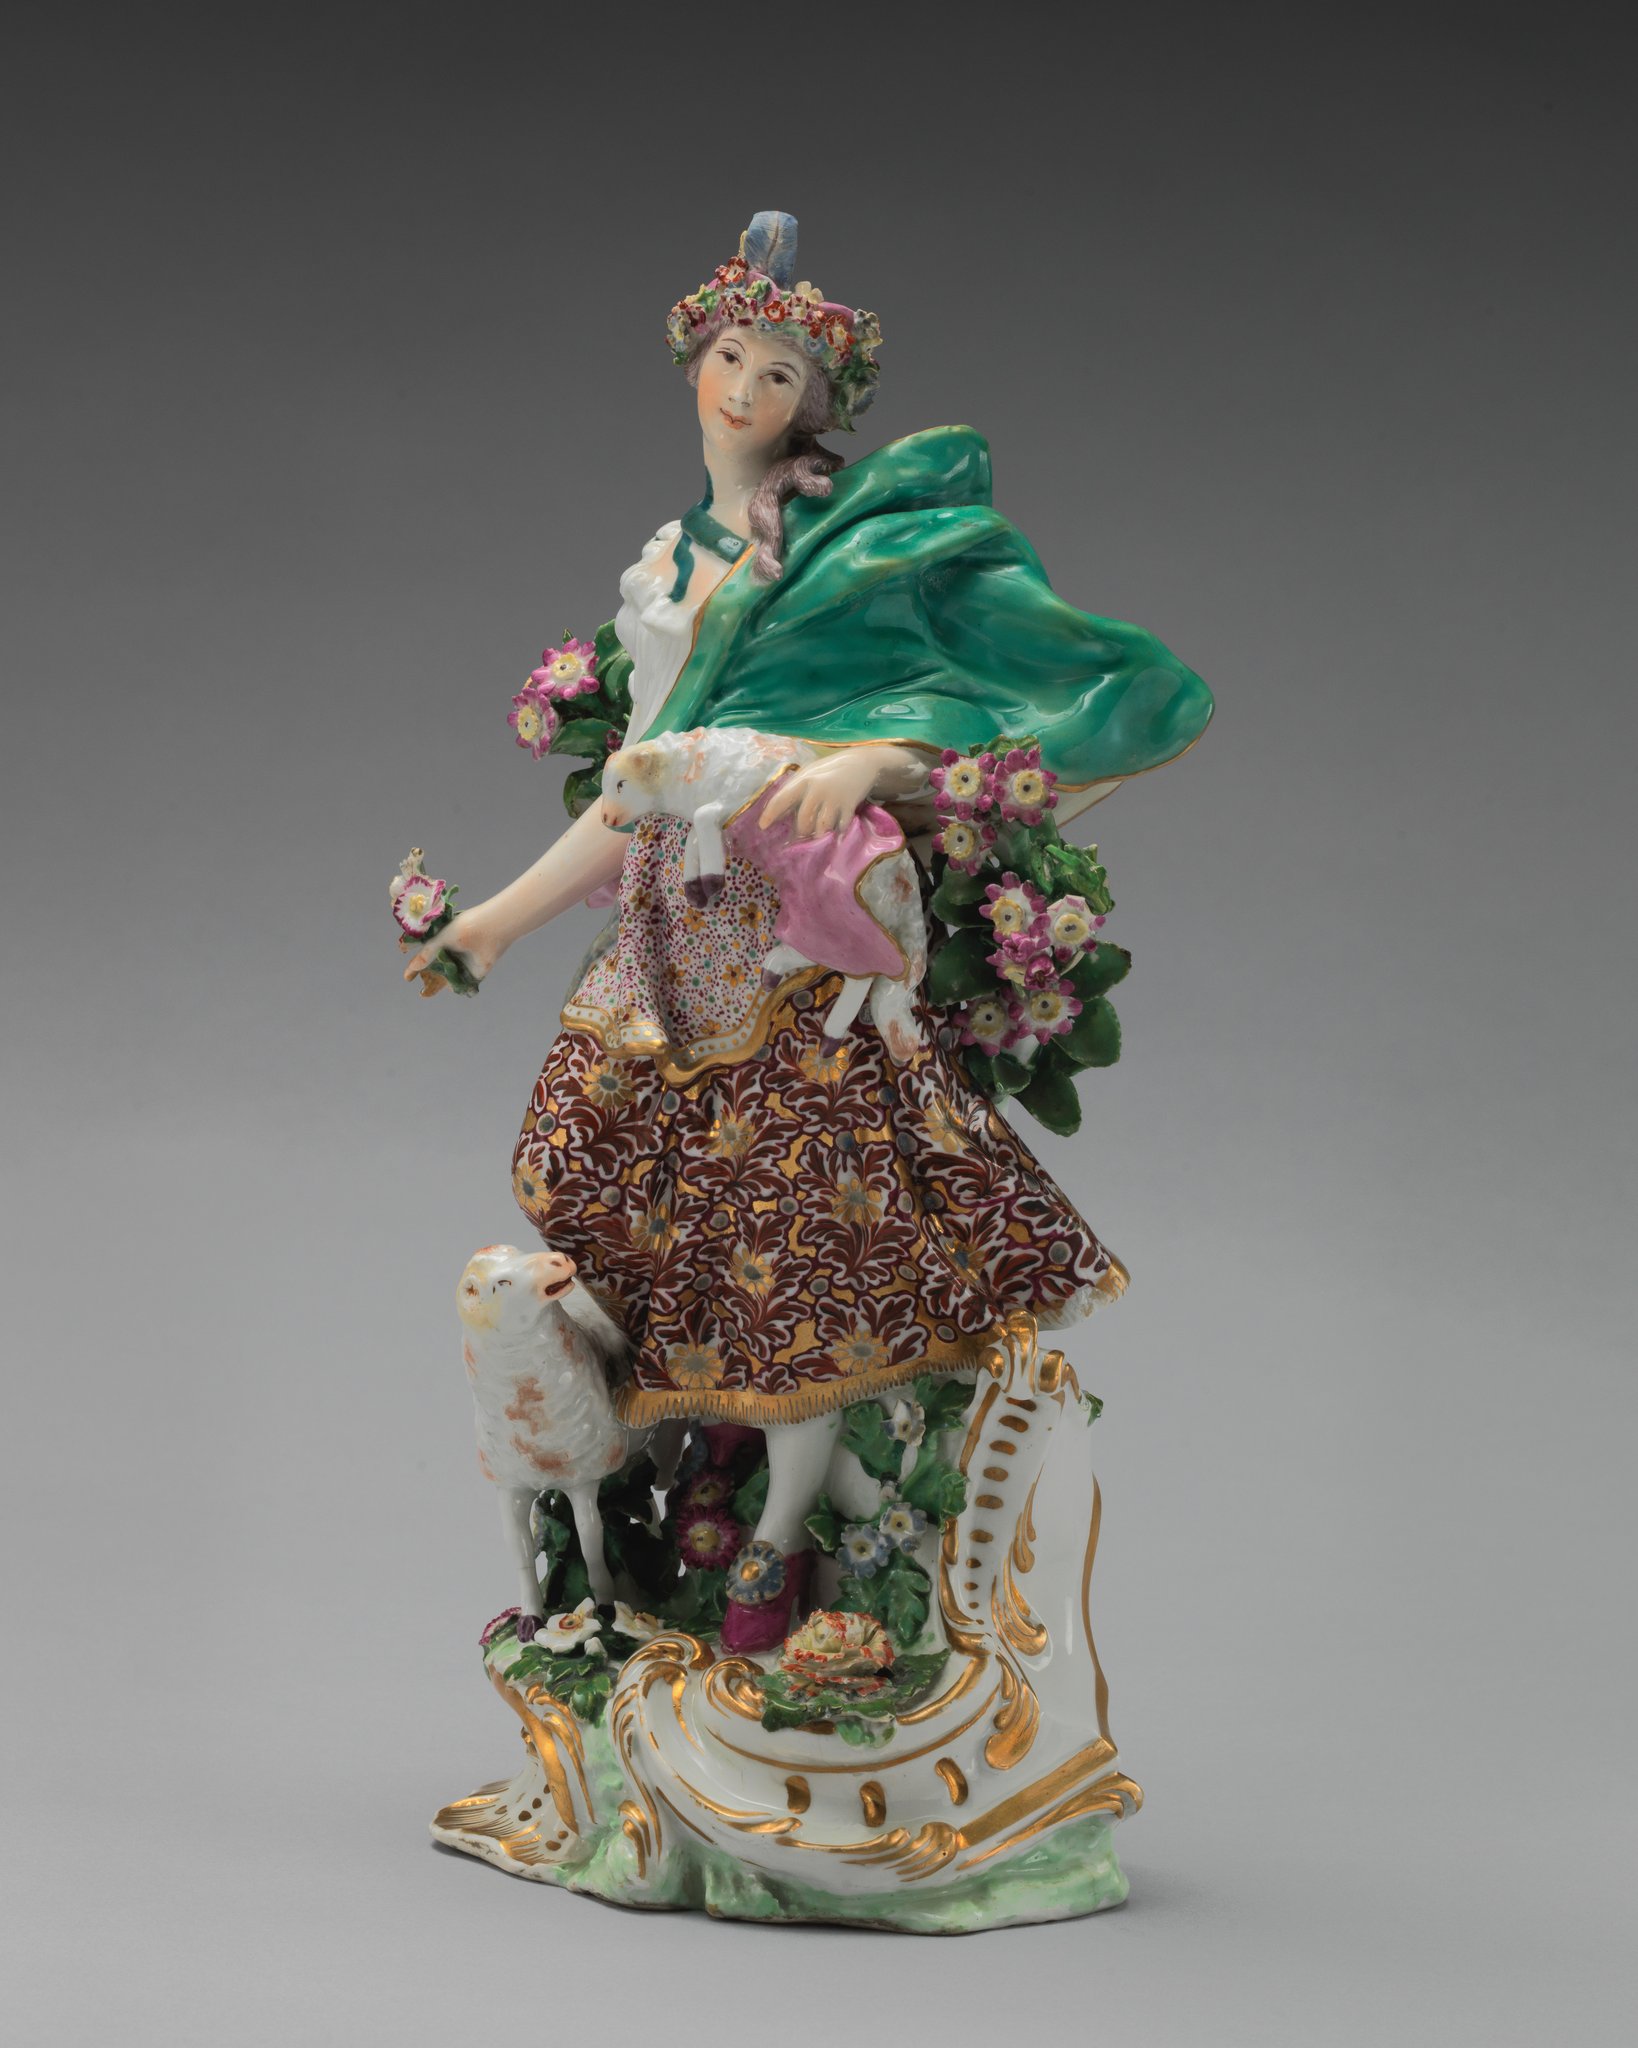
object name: figure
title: Shepherdess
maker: chelsea porcelain manufactory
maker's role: factory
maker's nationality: british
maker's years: 1744-1784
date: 1765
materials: soft paste porcelain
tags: women,sheep